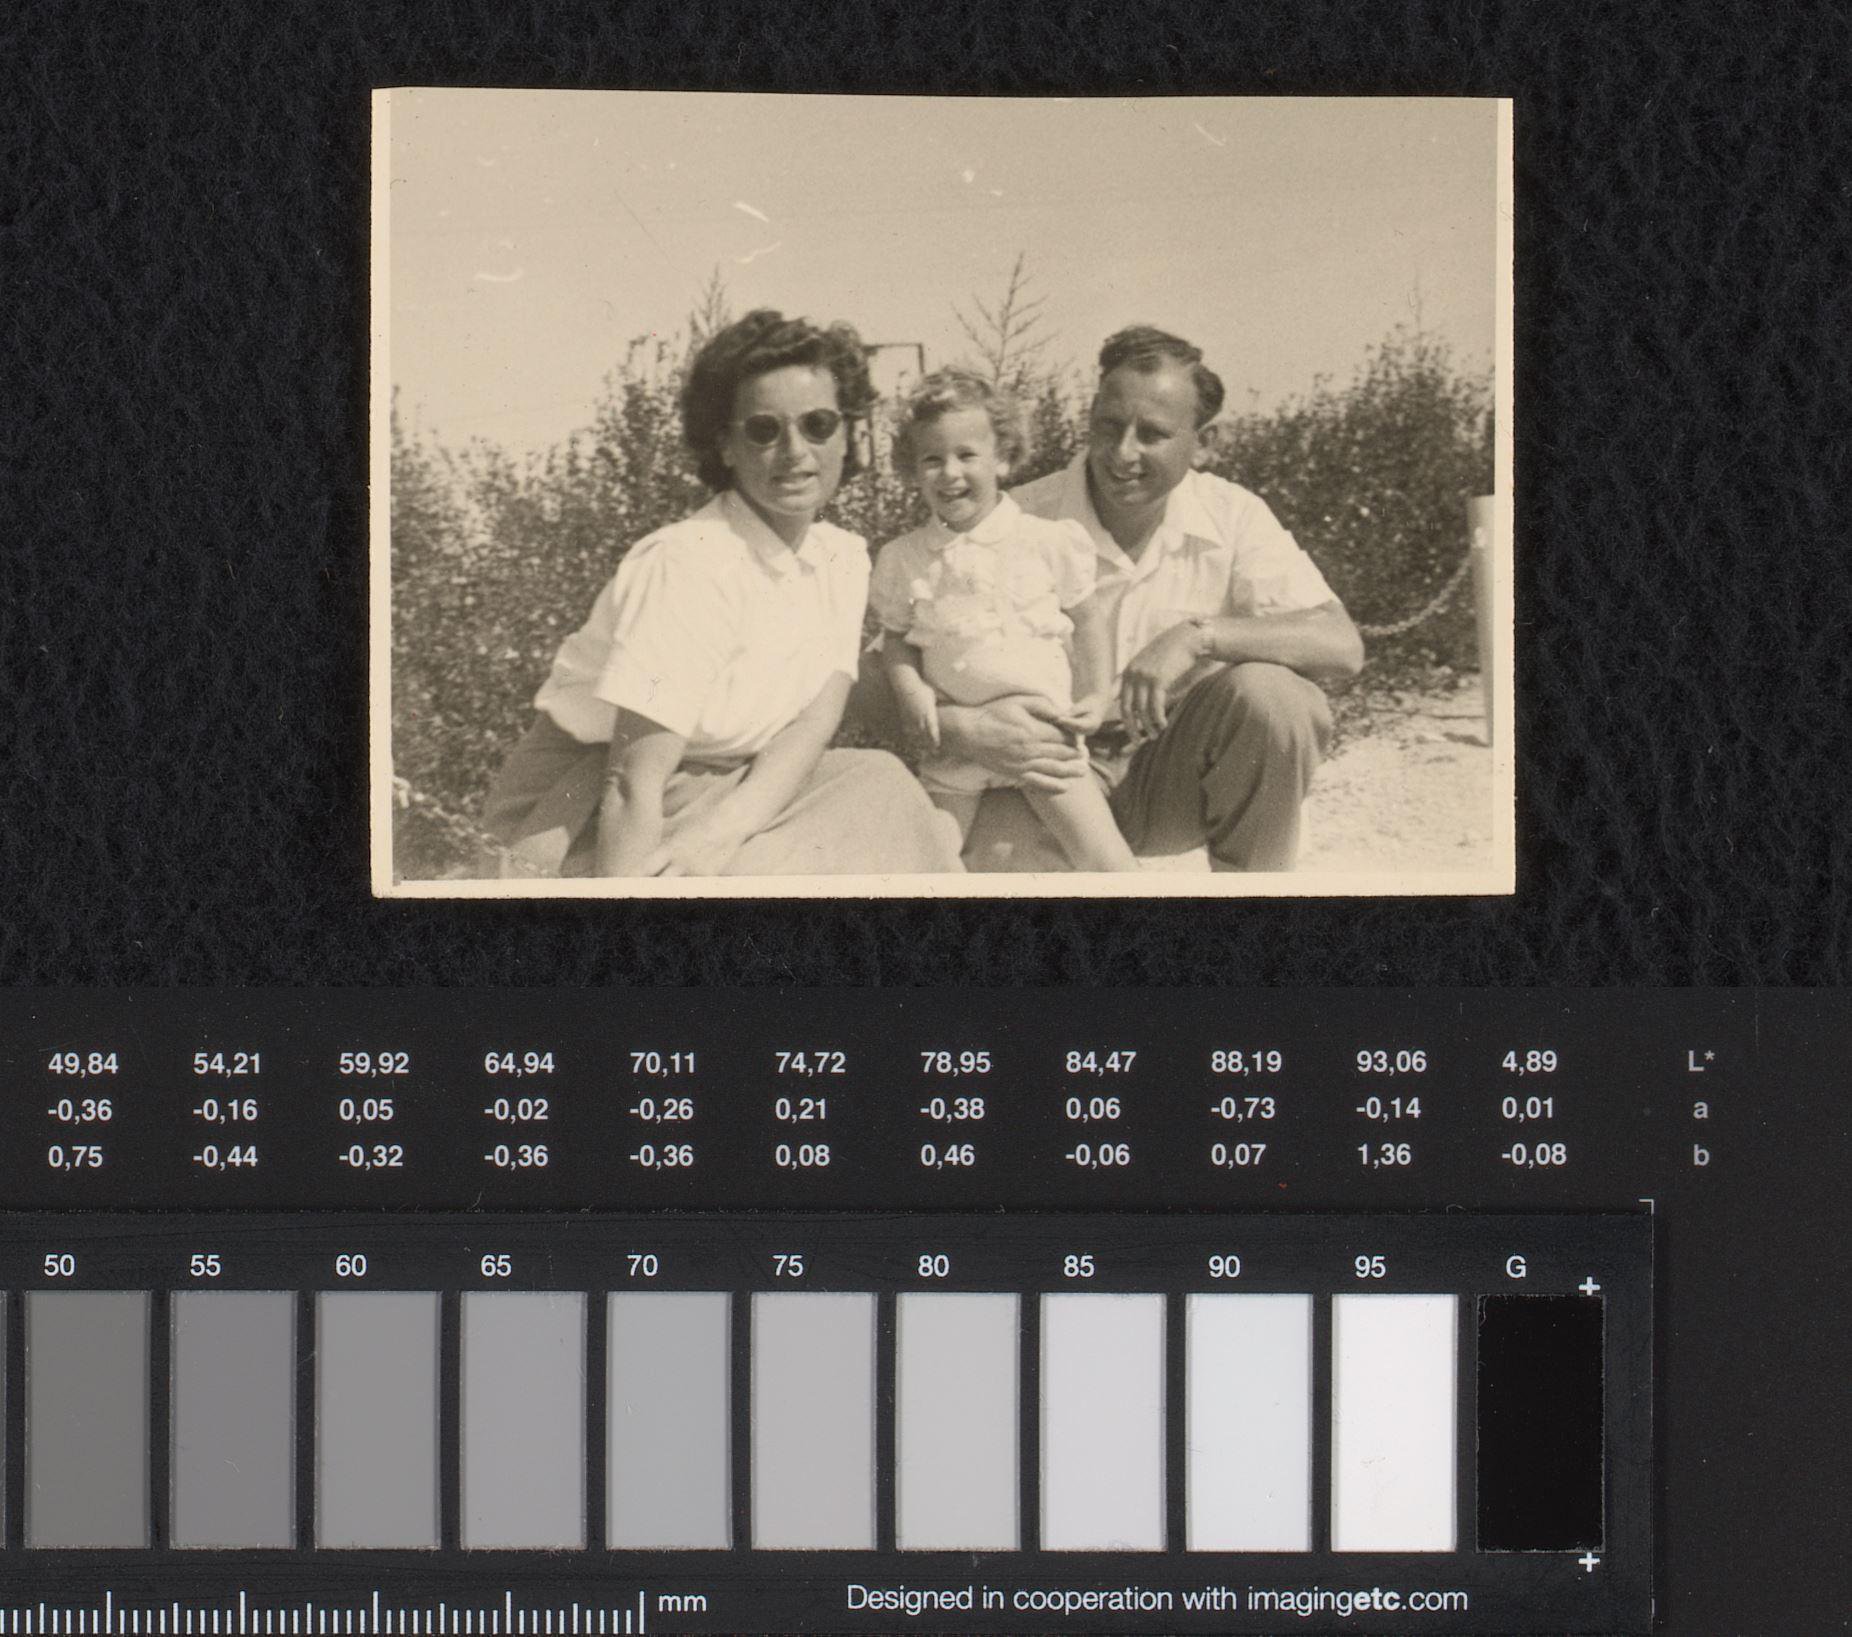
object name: photograph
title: Gezin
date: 1949-1969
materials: photographic support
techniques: gelatin silver print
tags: family group, especially parents with their child(ren)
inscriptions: inscription: ‘Wir drei! Erinnerst Du ... ? Eure Fanny, Macki, Raje.’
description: Man, vrouw en dochter. Vrienden van Isabel Wachenheimer. Losse foto voorin het fotoalbum met diverse foto's van de jeugd van Isabel Wachenheimer voor en tijdens de oorlog en diverse momenten van haar volwassen leven na de Tweede Wereldoorlog.